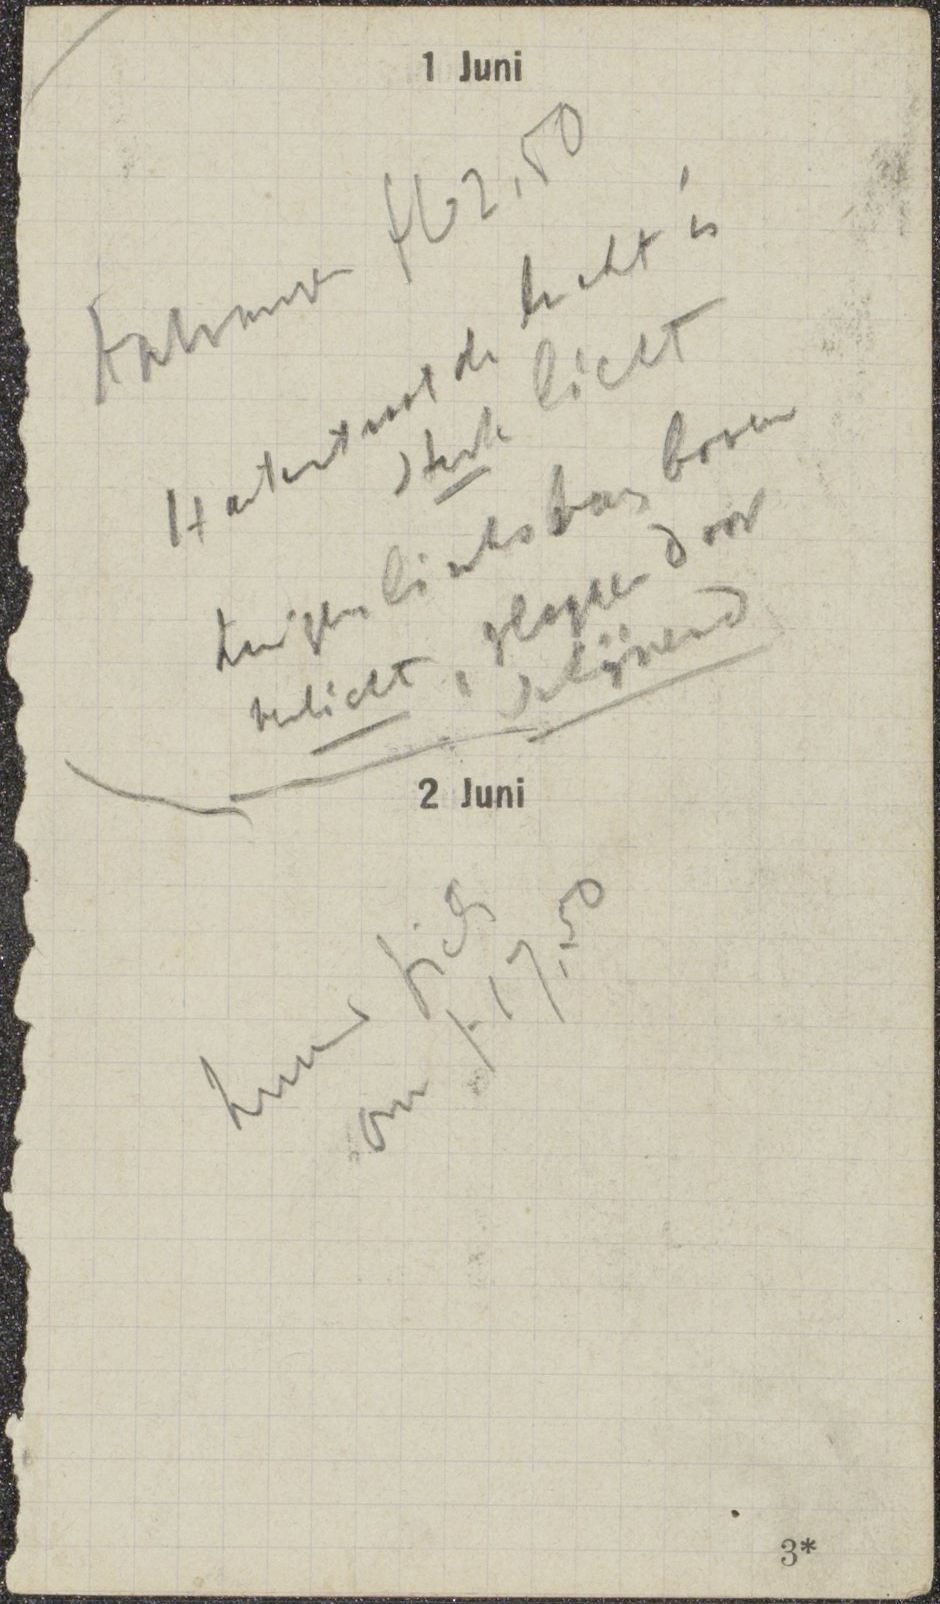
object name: drawing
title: Annotaties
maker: george hendrik breitner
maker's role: draughtsman, painter, print maker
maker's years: 1857-1923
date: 1873-1923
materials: chalk, pencil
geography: amsterdam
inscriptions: annotation: ‘Hartenstraat de lucht is/ sterk licht/ huizen links [...] boven/ verlicht, vlaggen door/ schijnend/ [...]’, annotation: ‘[...]’